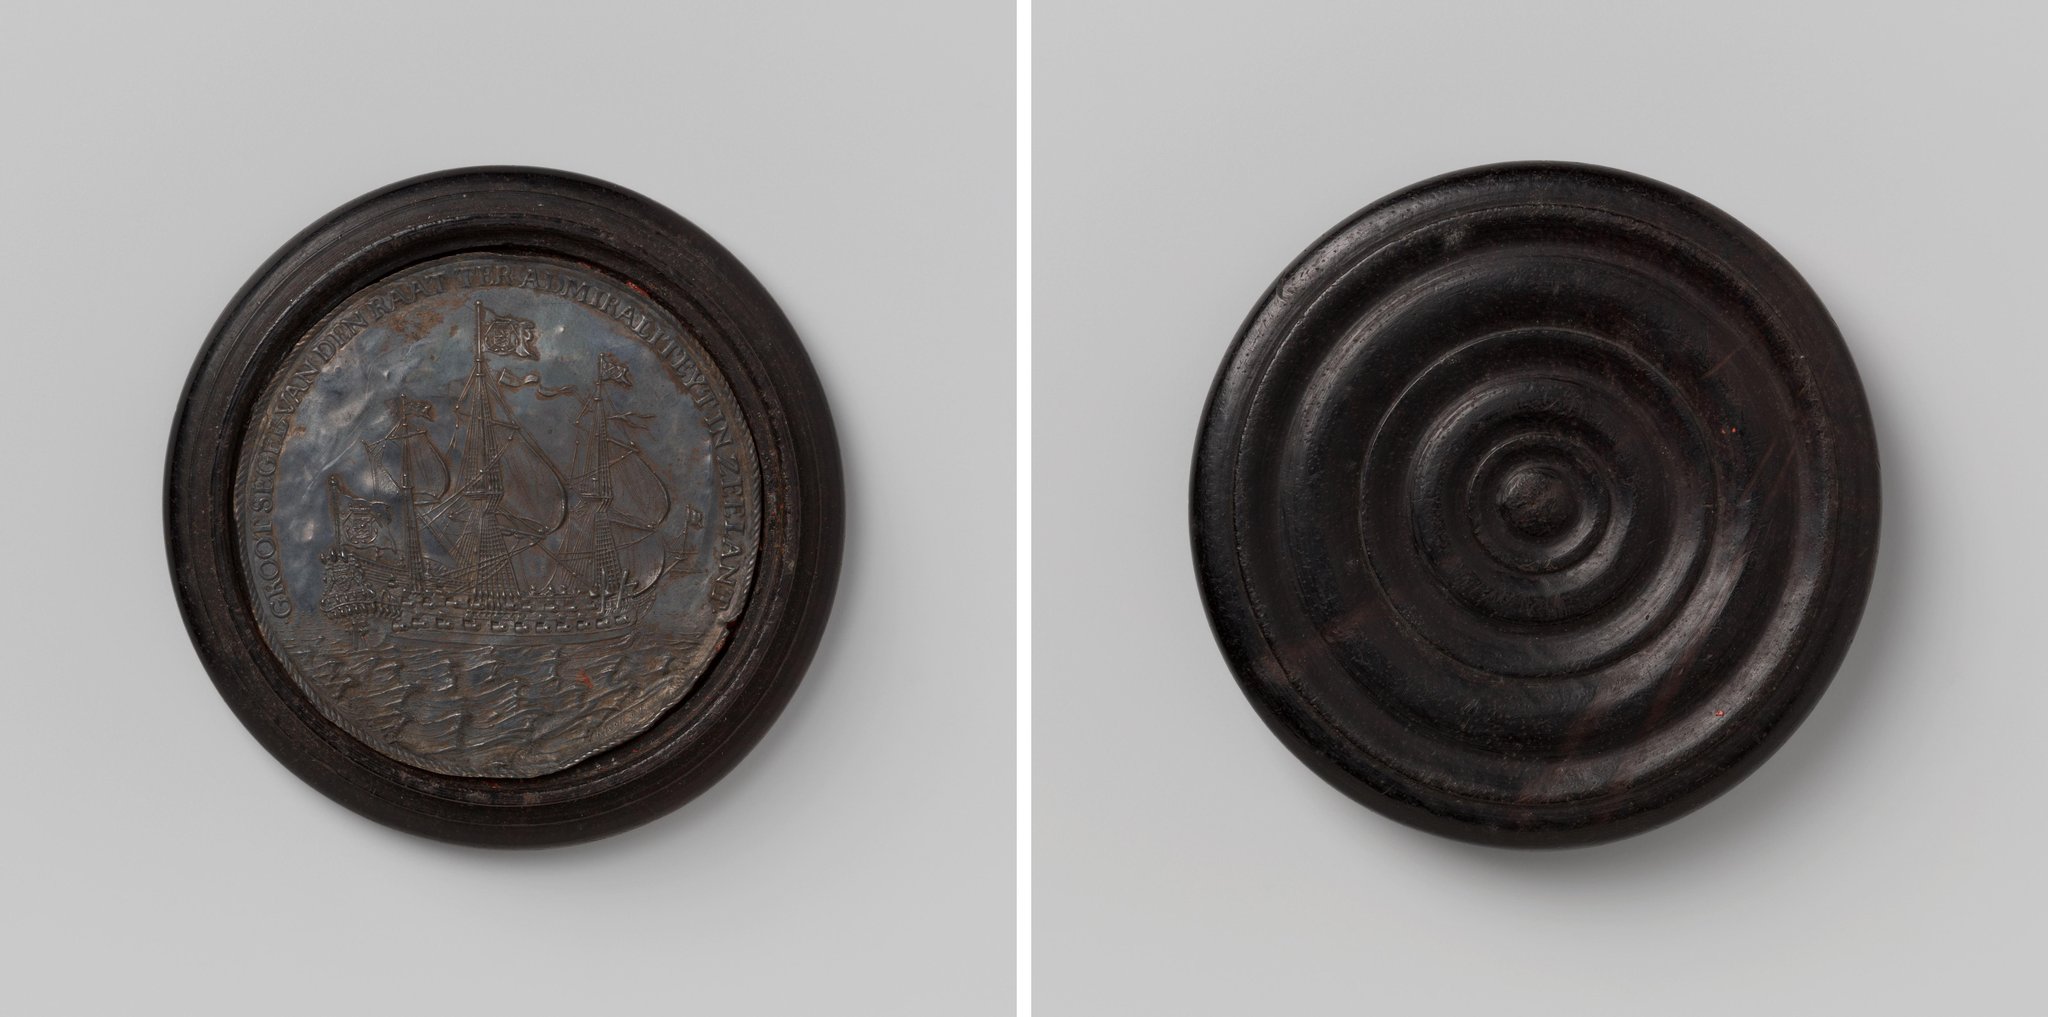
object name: zegelafdruk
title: Afdruk van het grootzegel voor de Admiraliteit te Zeeland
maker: matthijs hooft jr.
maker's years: 1660-1687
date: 1660-1687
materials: silver leaf, wood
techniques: striking, turning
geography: middelburg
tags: zeeland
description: Eenzijdige afdruk. Voorzijde: naar rechts varende driemaster met elf kanonnen op onderste en negen op bovenste dek binnen omschrift. Keerzijde: blanco; in mogelijk bijbehorende houten doos, waarin geheel verkruimelde lakafdruk.